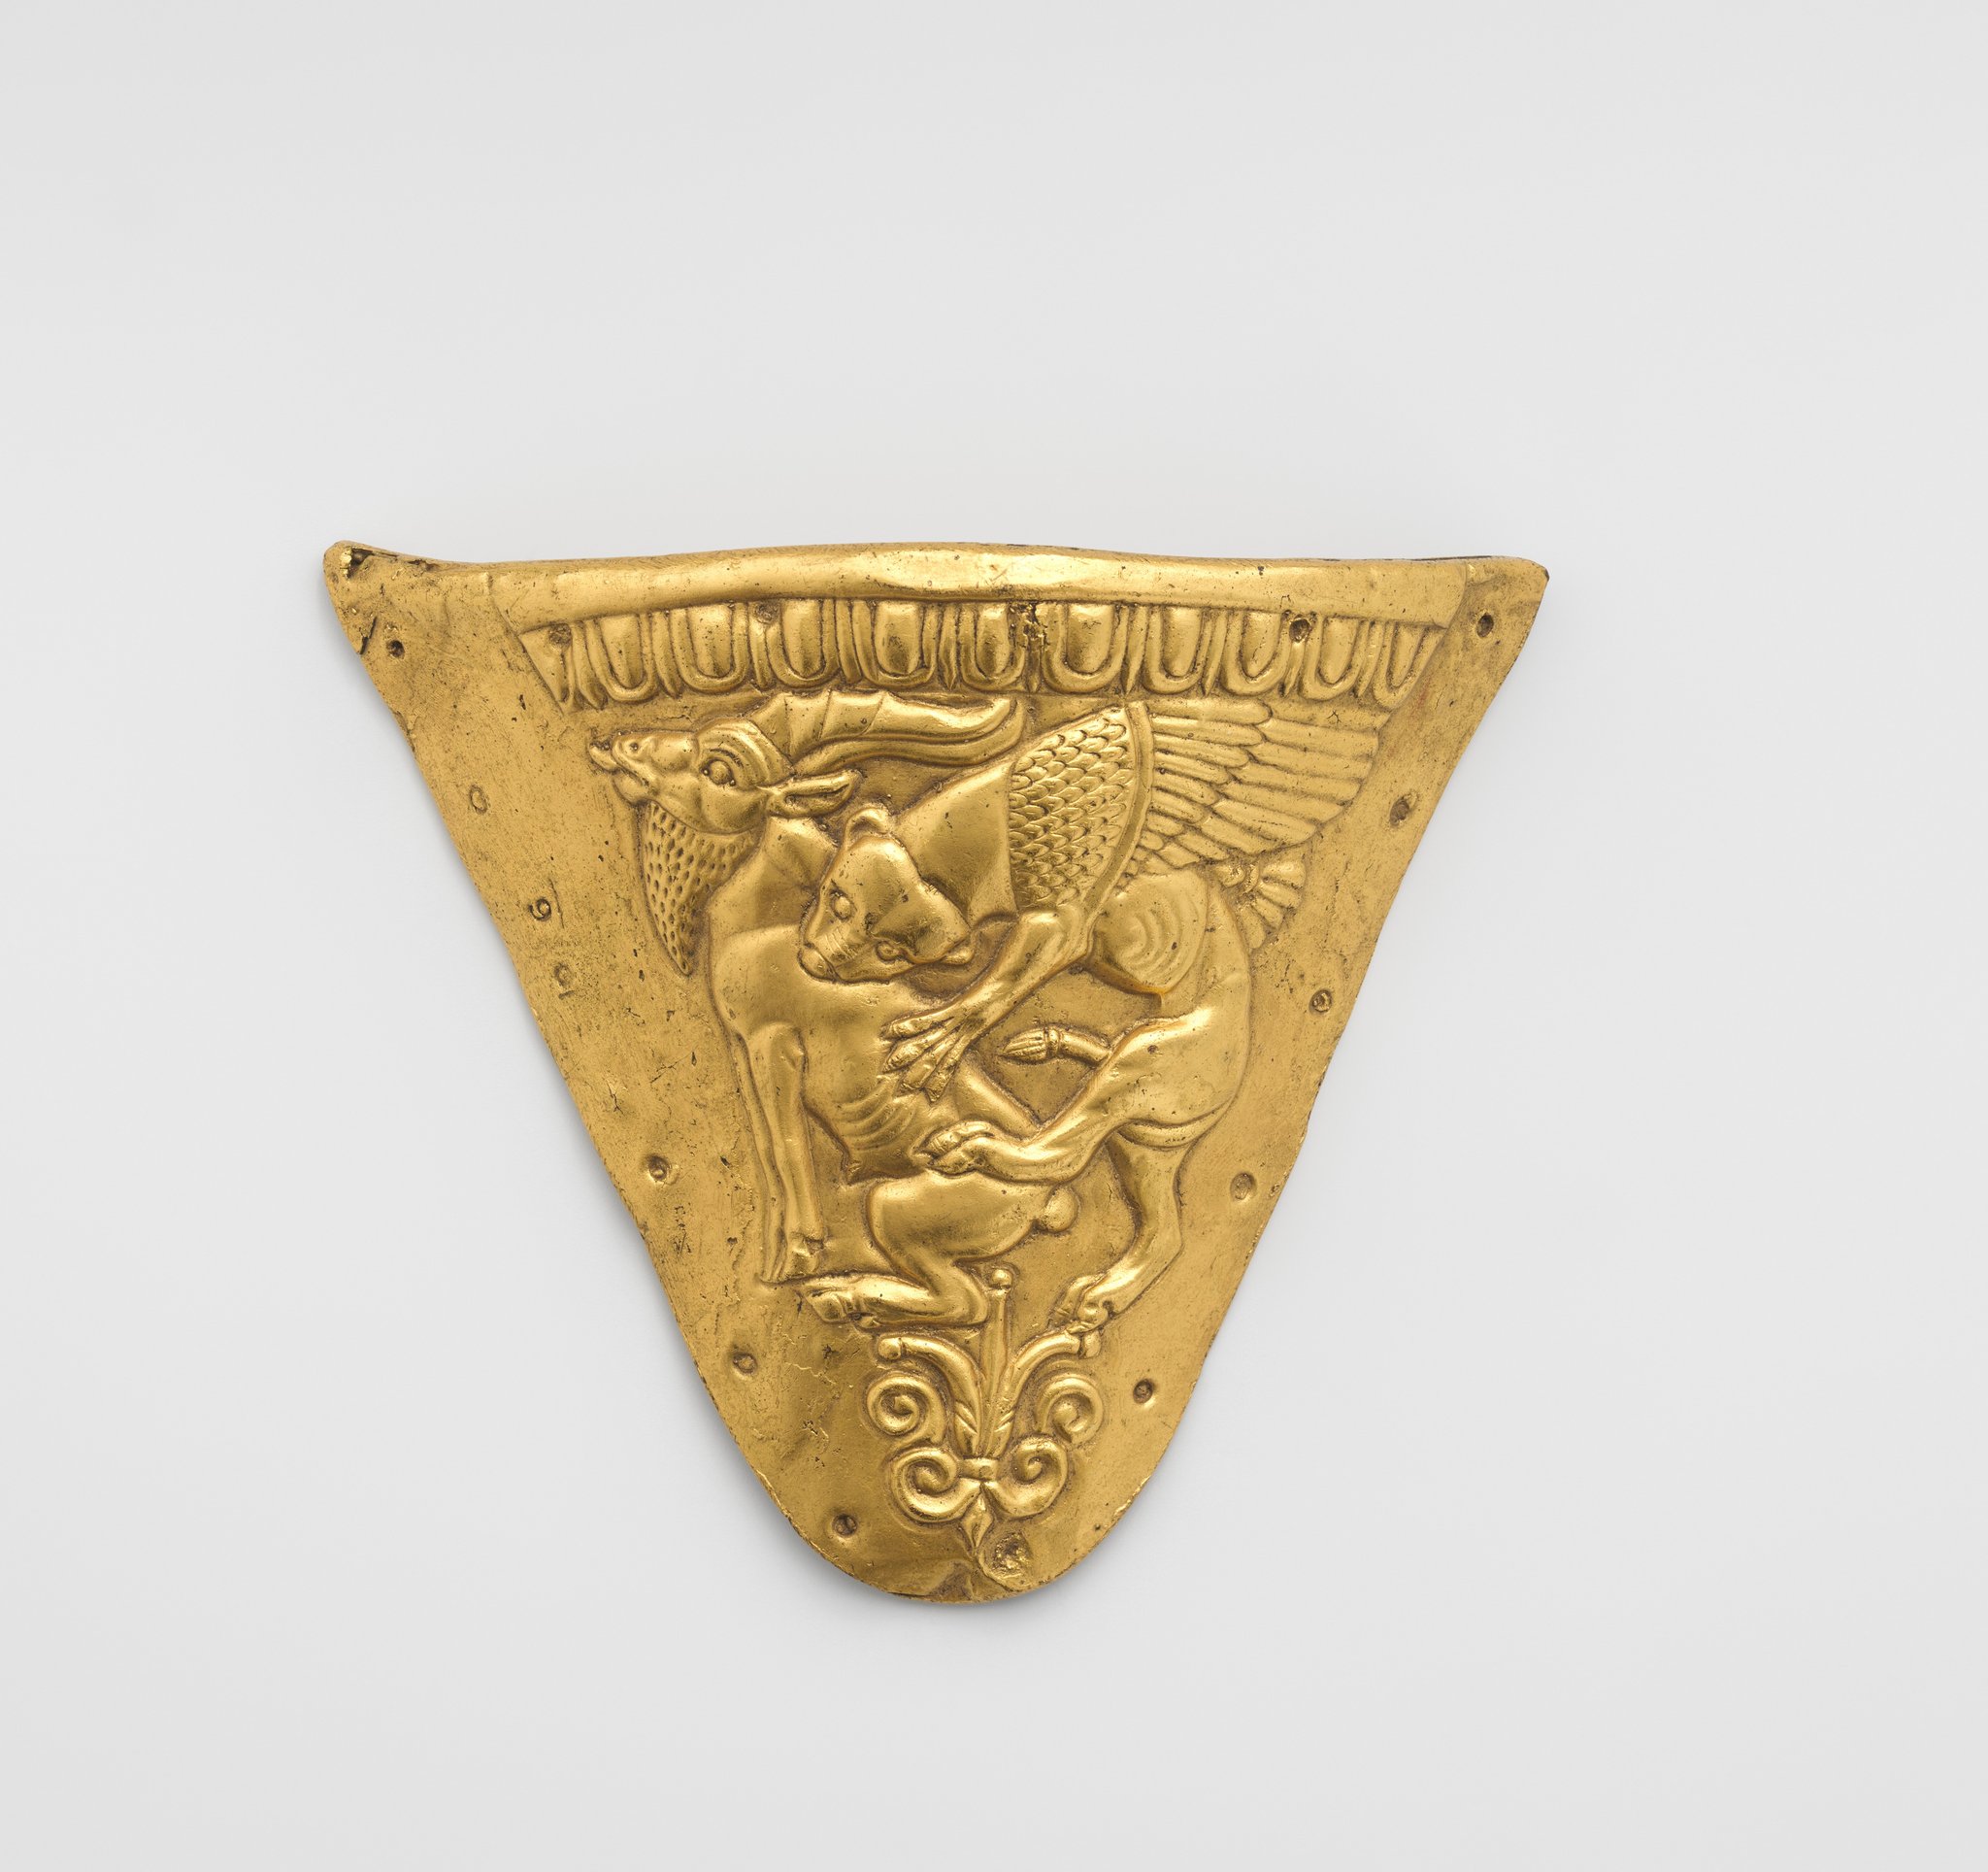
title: Reproduction of a Scythian plaque with animal combat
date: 1801-1900